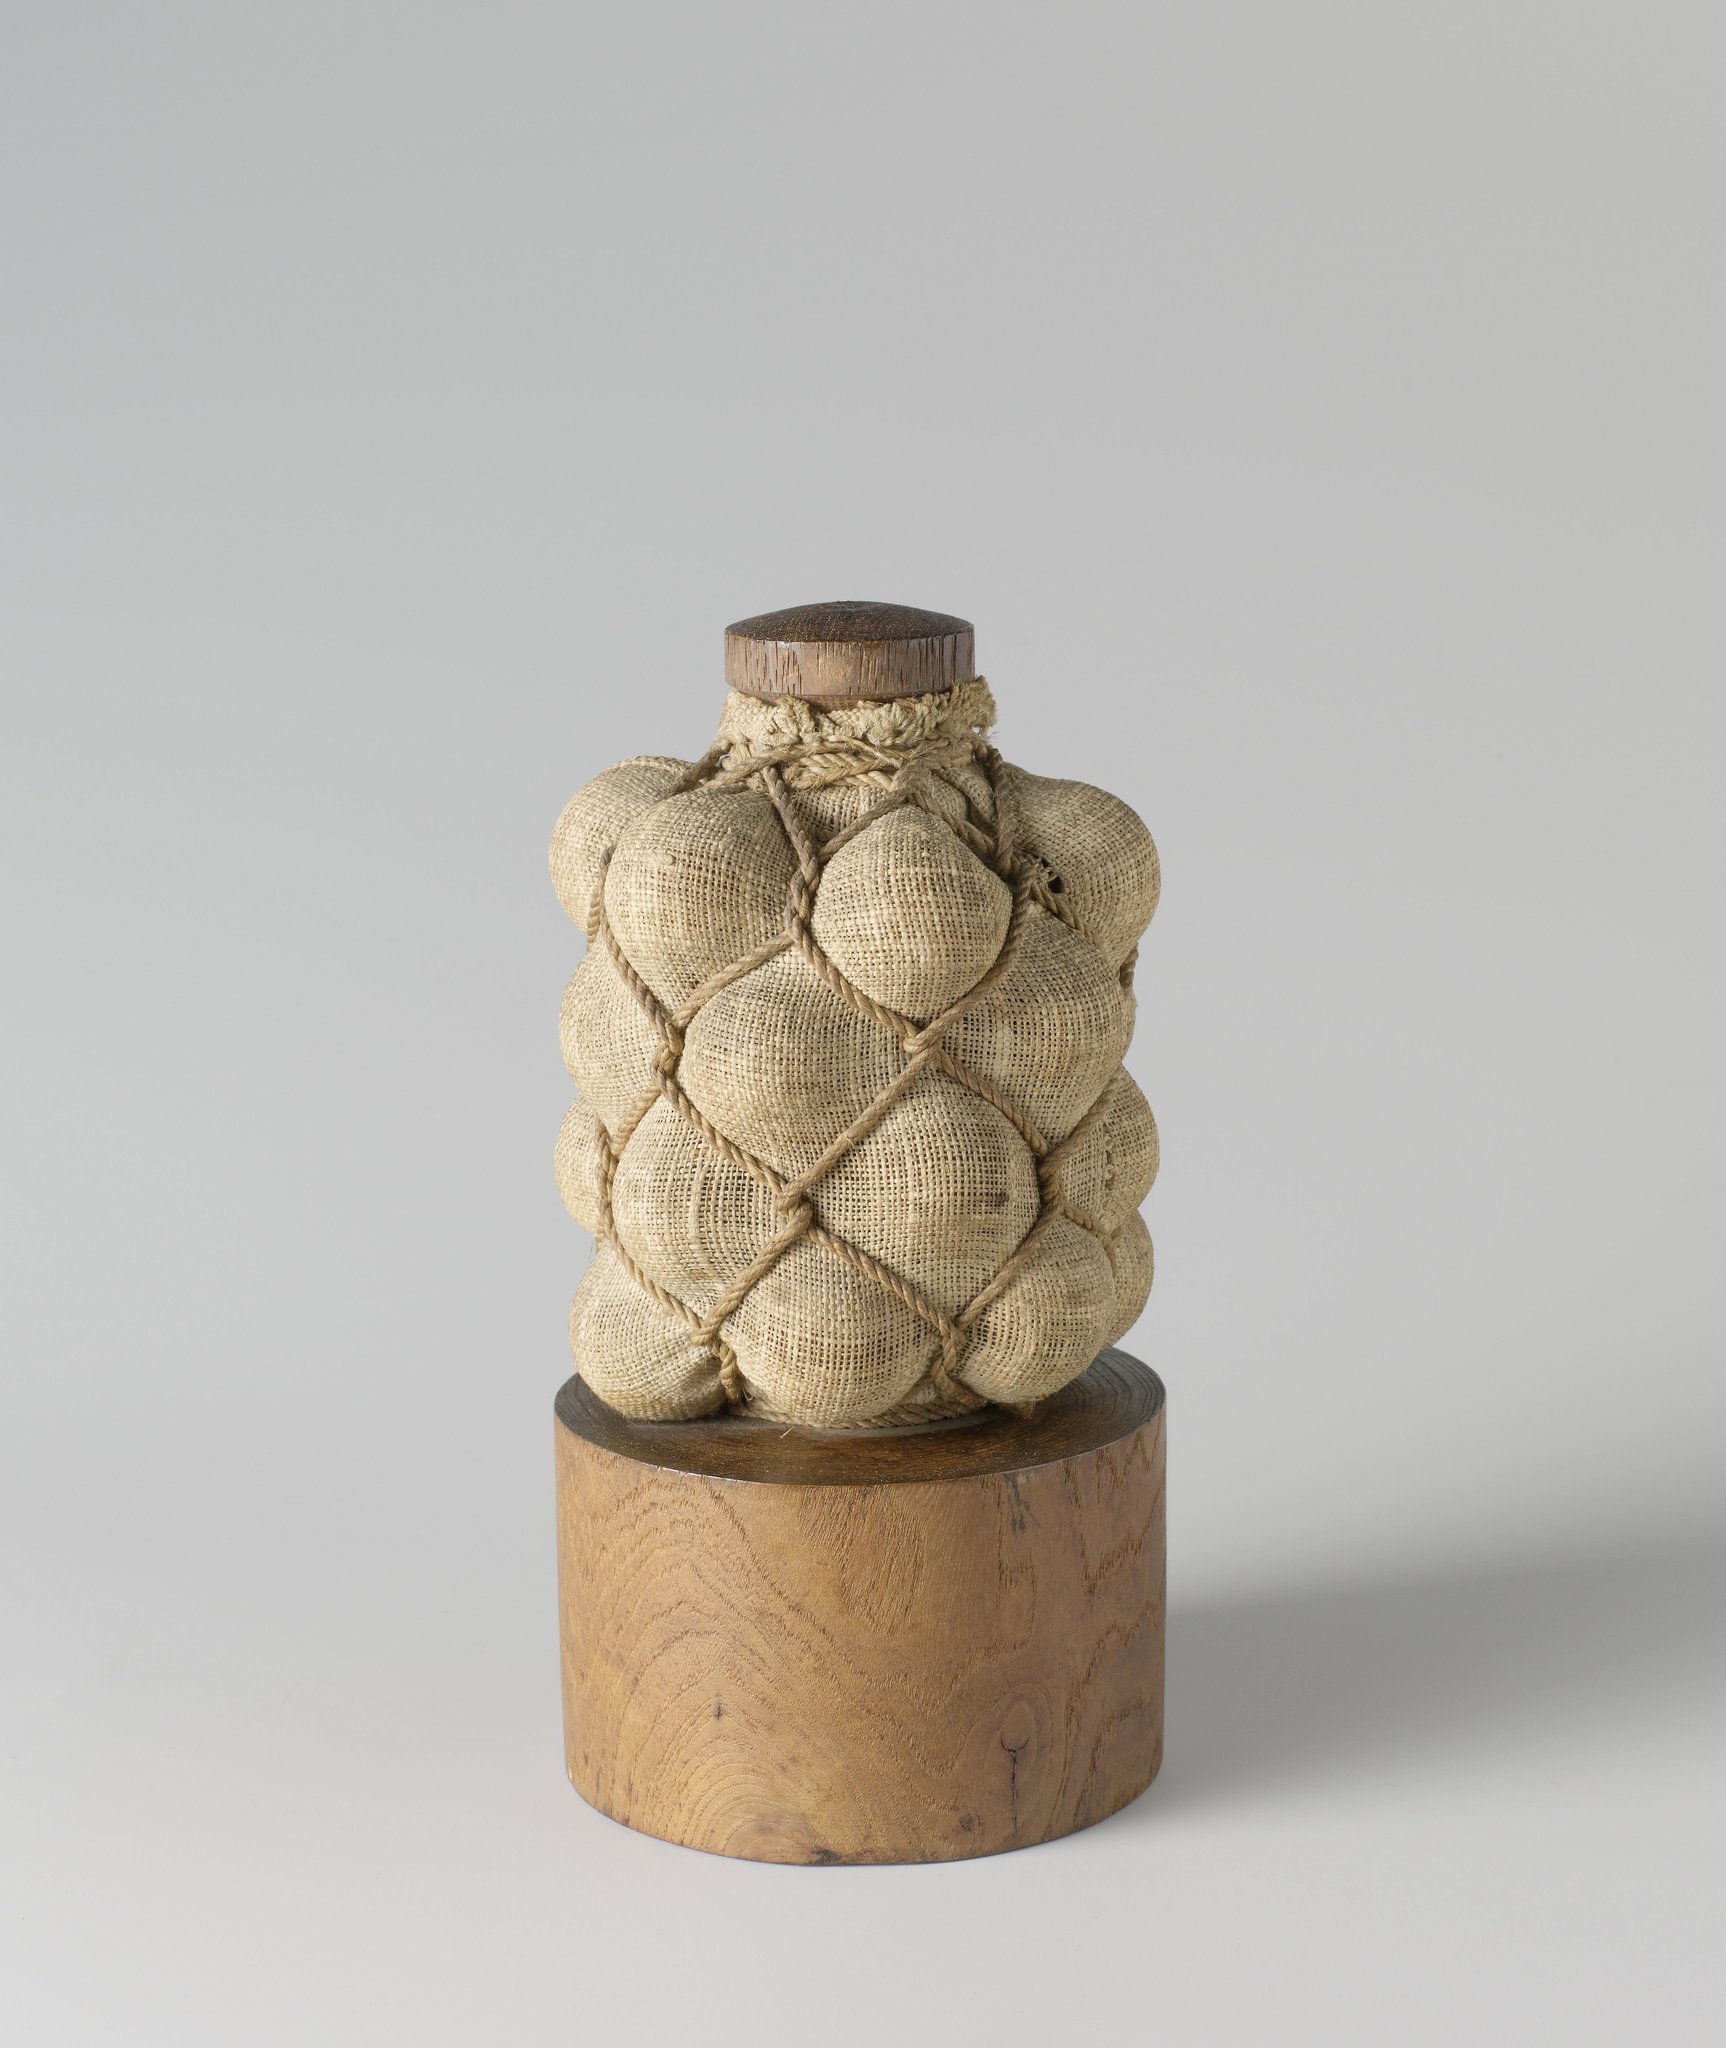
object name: scale model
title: Models of shot bundles (grapeshot)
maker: Anonymous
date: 1750-1800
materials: iron, linen, wood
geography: netherlands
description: A cannon could be loaded with a single cannonball or bundles of smaller projectiles, such as this ‘grapeshot’. Grapeshot consisted of a canvas bag filled with iron balls or metal slugs, tied together so that it resembled a bunch of grapes. It was used to hit living targets – horses and soldiers – at close range. The Dutch word for machine gun (mitrailleur) comes from the French term for grapeshot (boîte à mitraille).